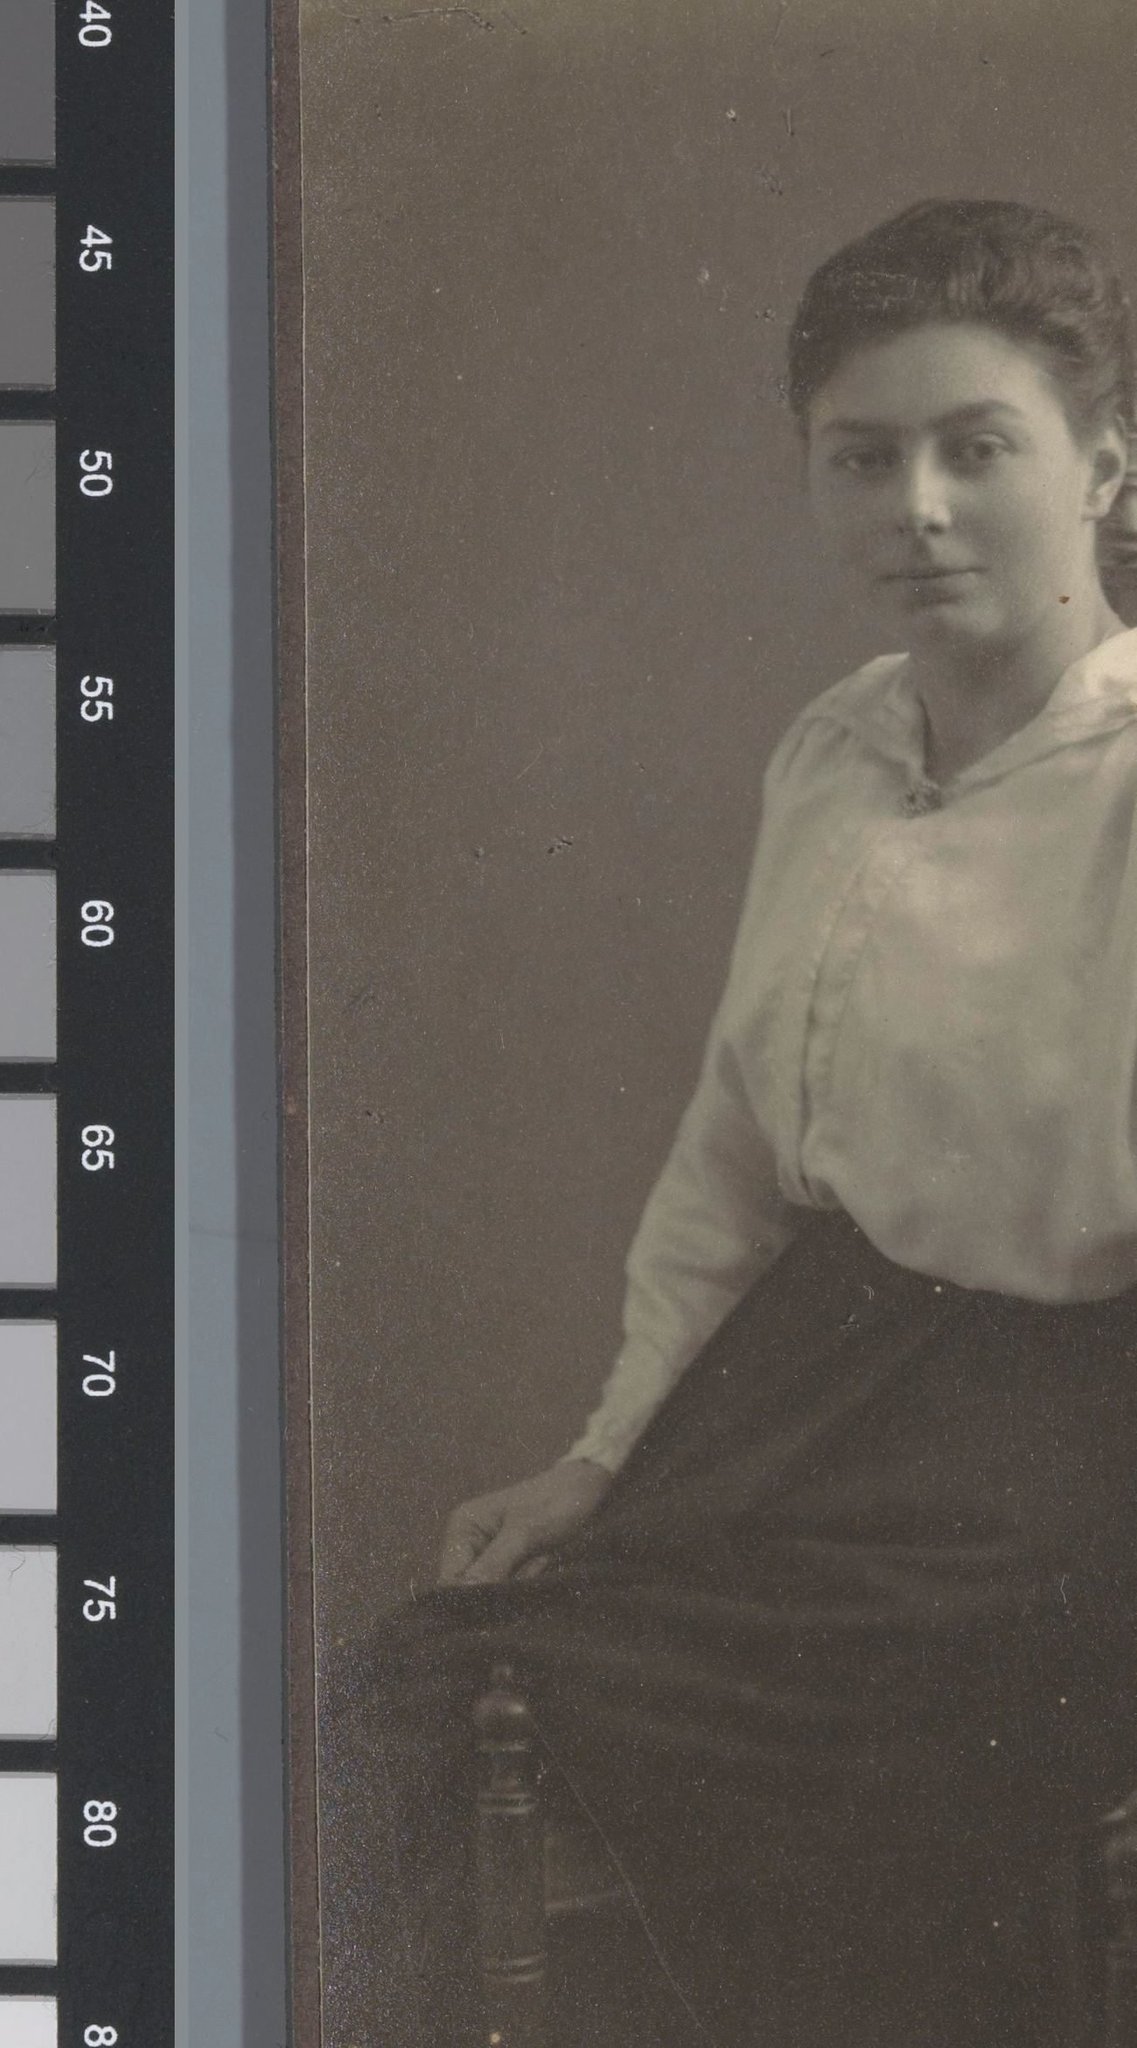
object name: carte de visite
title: Portret van een onbekende jonge vrouw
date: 1911-1914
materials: paper, cardboard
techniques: gelatin silver print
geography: amsterdam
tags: adolescent, young woman, maiden, anonymous historical person portrayed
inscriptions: number: ‘4830’, address: ‘AMSTERDAM/ Kalverstraat 103.’